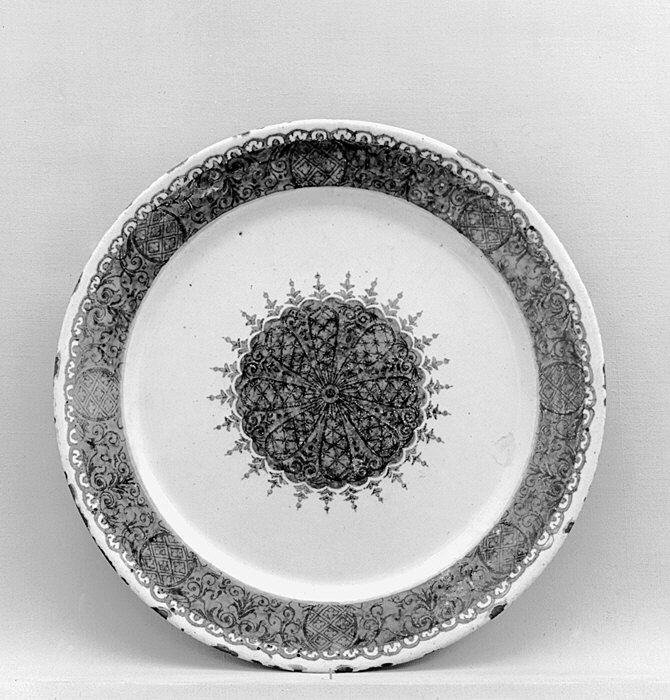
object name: plate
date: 1725-1733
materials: faience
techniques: glazing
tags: flowers